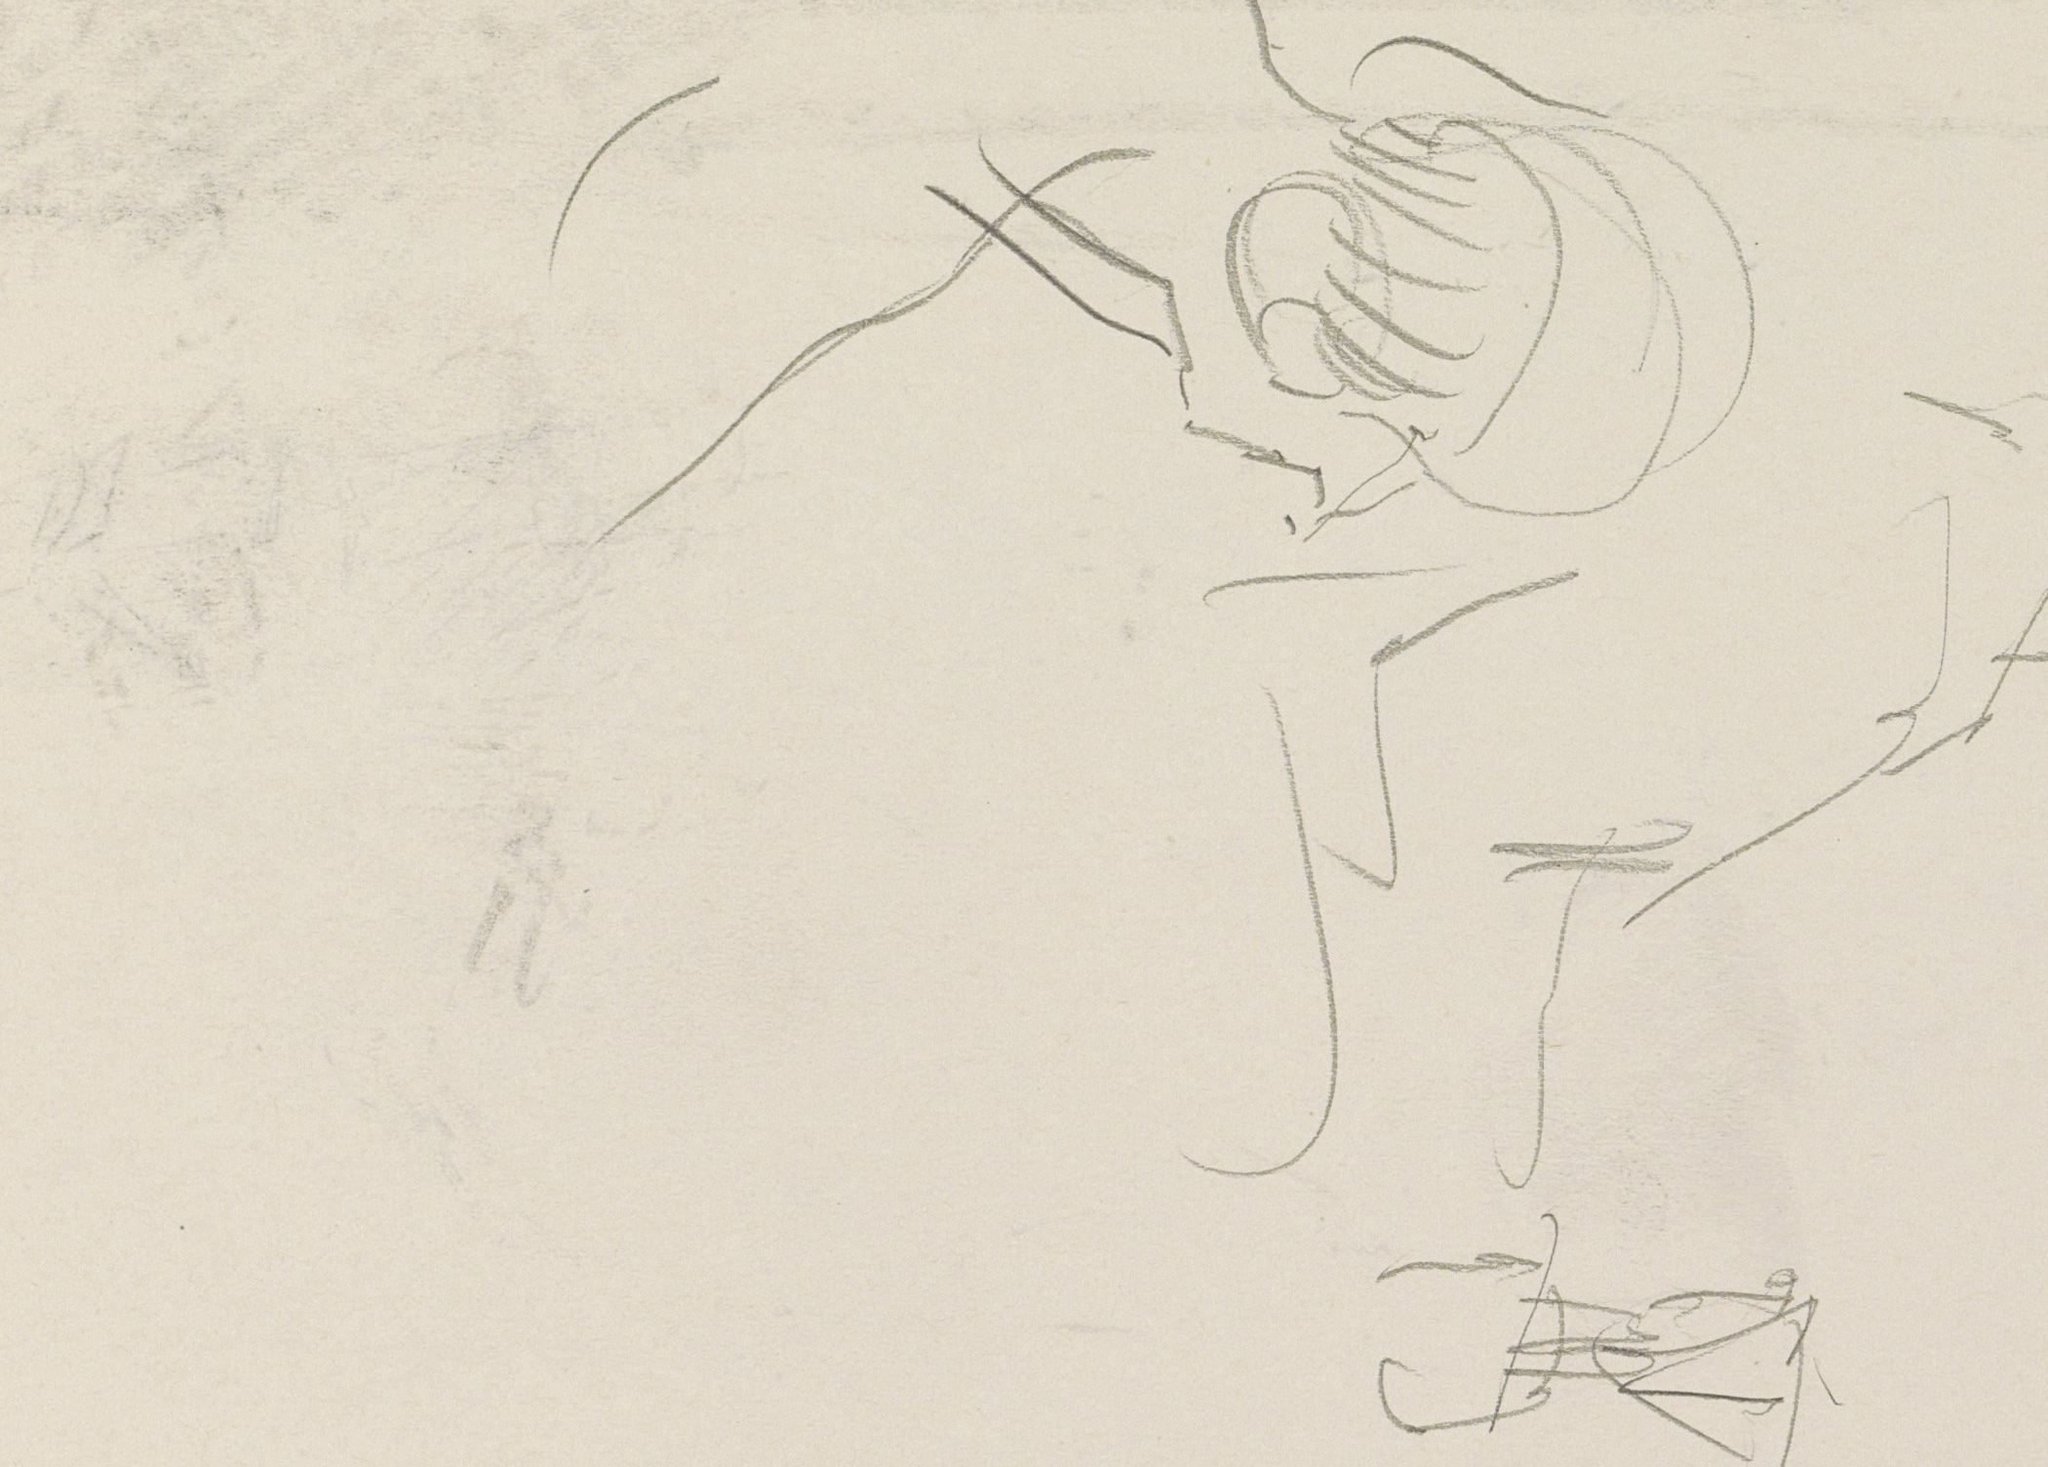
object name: sketchbook leaf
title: Hoofd van een man en vrouw, in profiel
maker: isaac israels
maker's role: draughtsman, painter, print maker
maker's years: 1865-1934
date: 1915-1934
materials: paper, pencil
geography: the hague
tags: head (human) (+ sideview, profile), head (human) - aa - female human figure (+ sideview, profile)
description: Blad 17 verso uit schetsboek VI met 33 bladen.